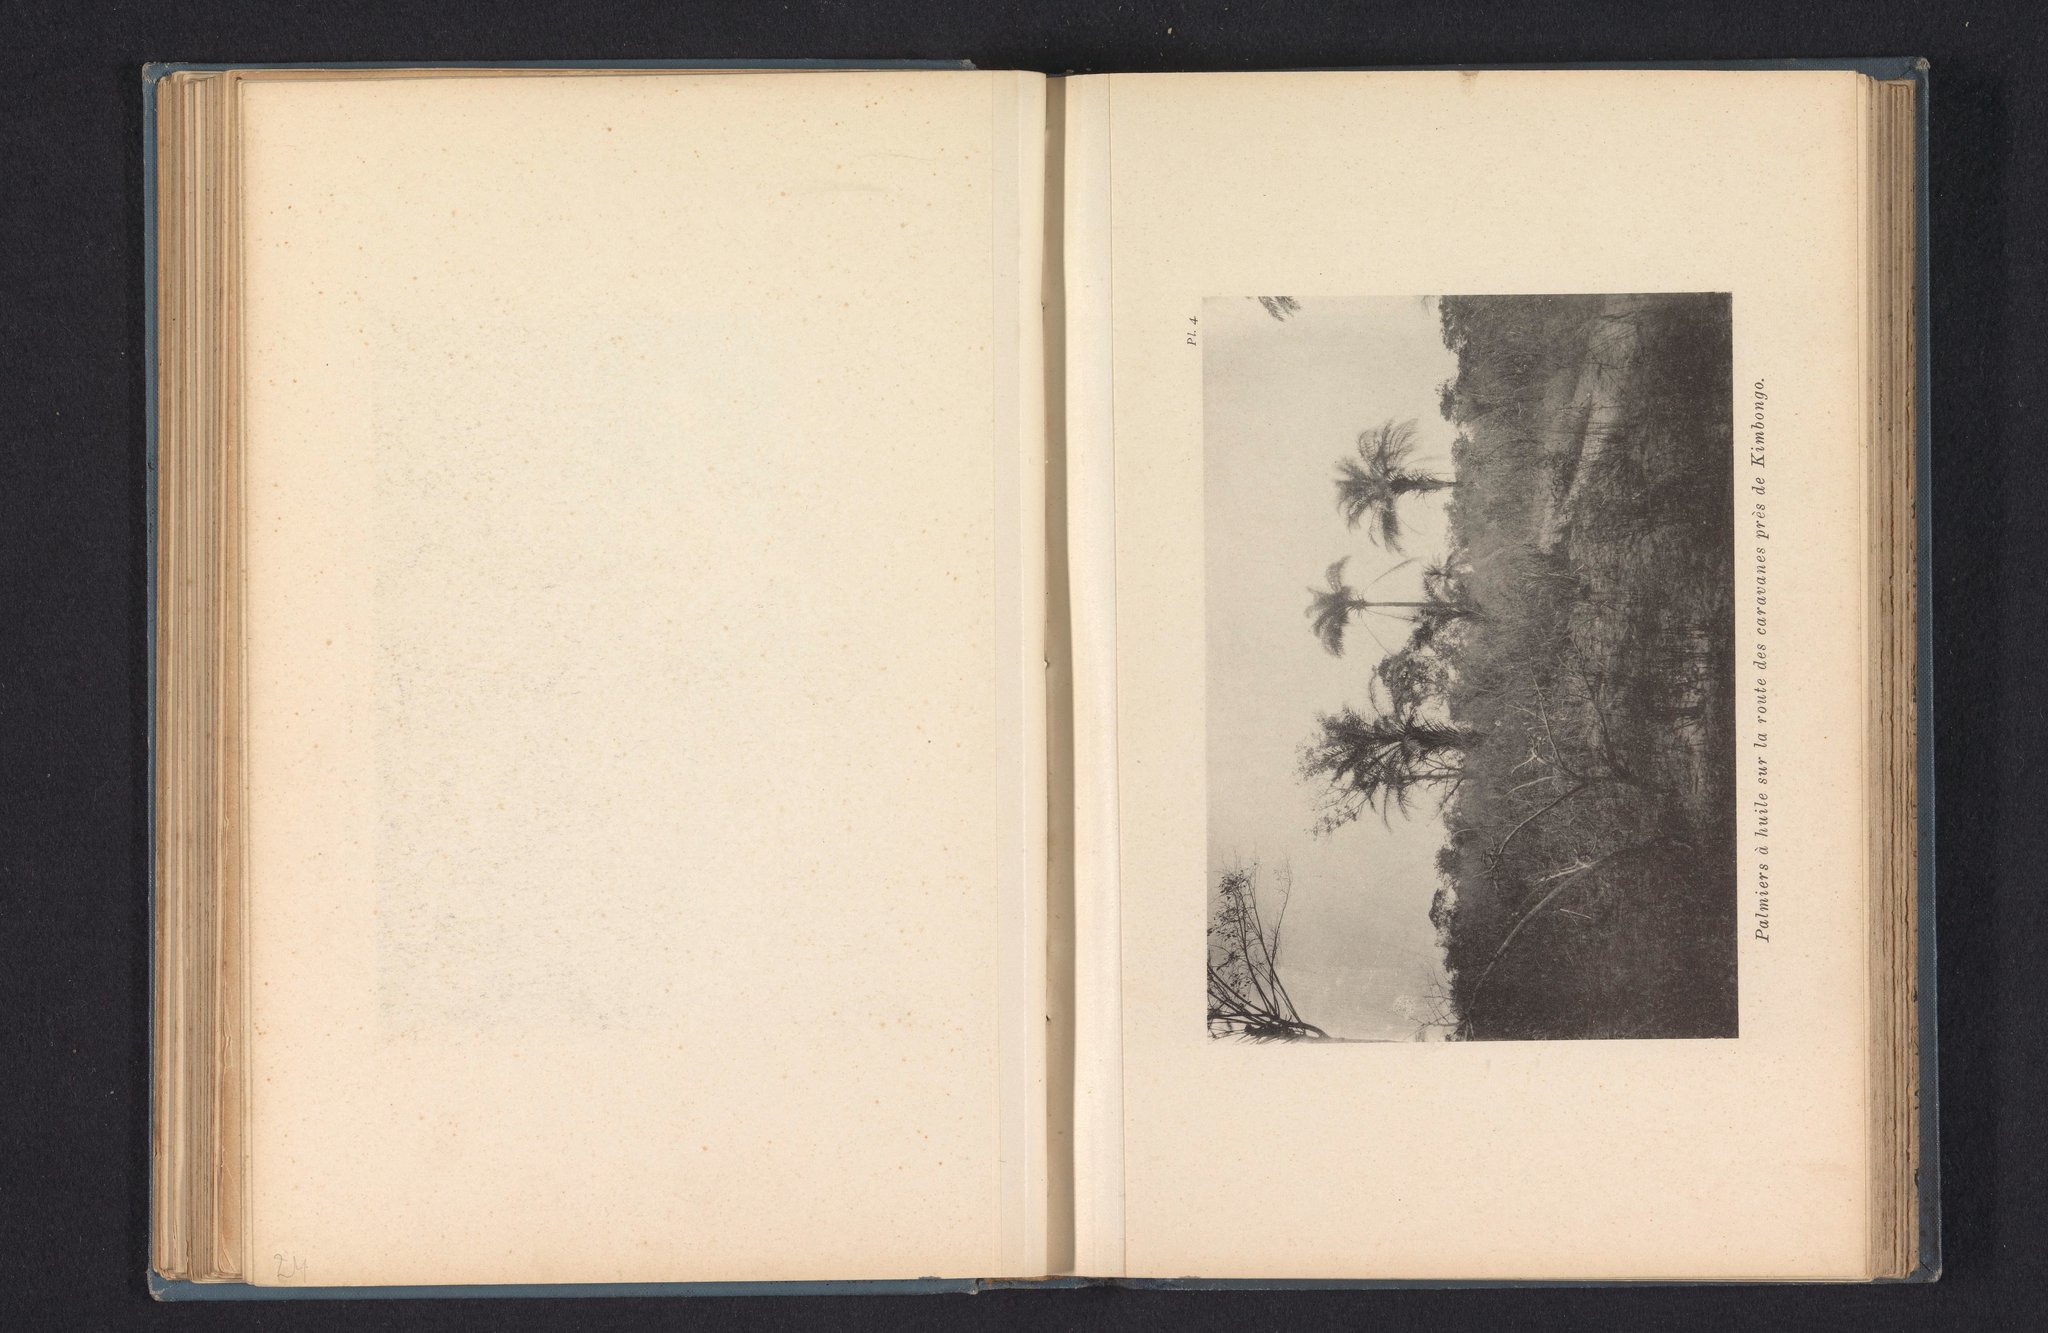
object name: photomechanical print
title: Palmiers à huile sur la route des caravanes près de Kimbongo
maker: franz thonner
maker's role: botanicus, ontdekkingsreiziger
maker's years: 1863-1928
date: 1896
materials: paper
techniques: photograph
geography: congo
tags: trees: palm-tree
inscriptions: number: ‘Pl. 4.’